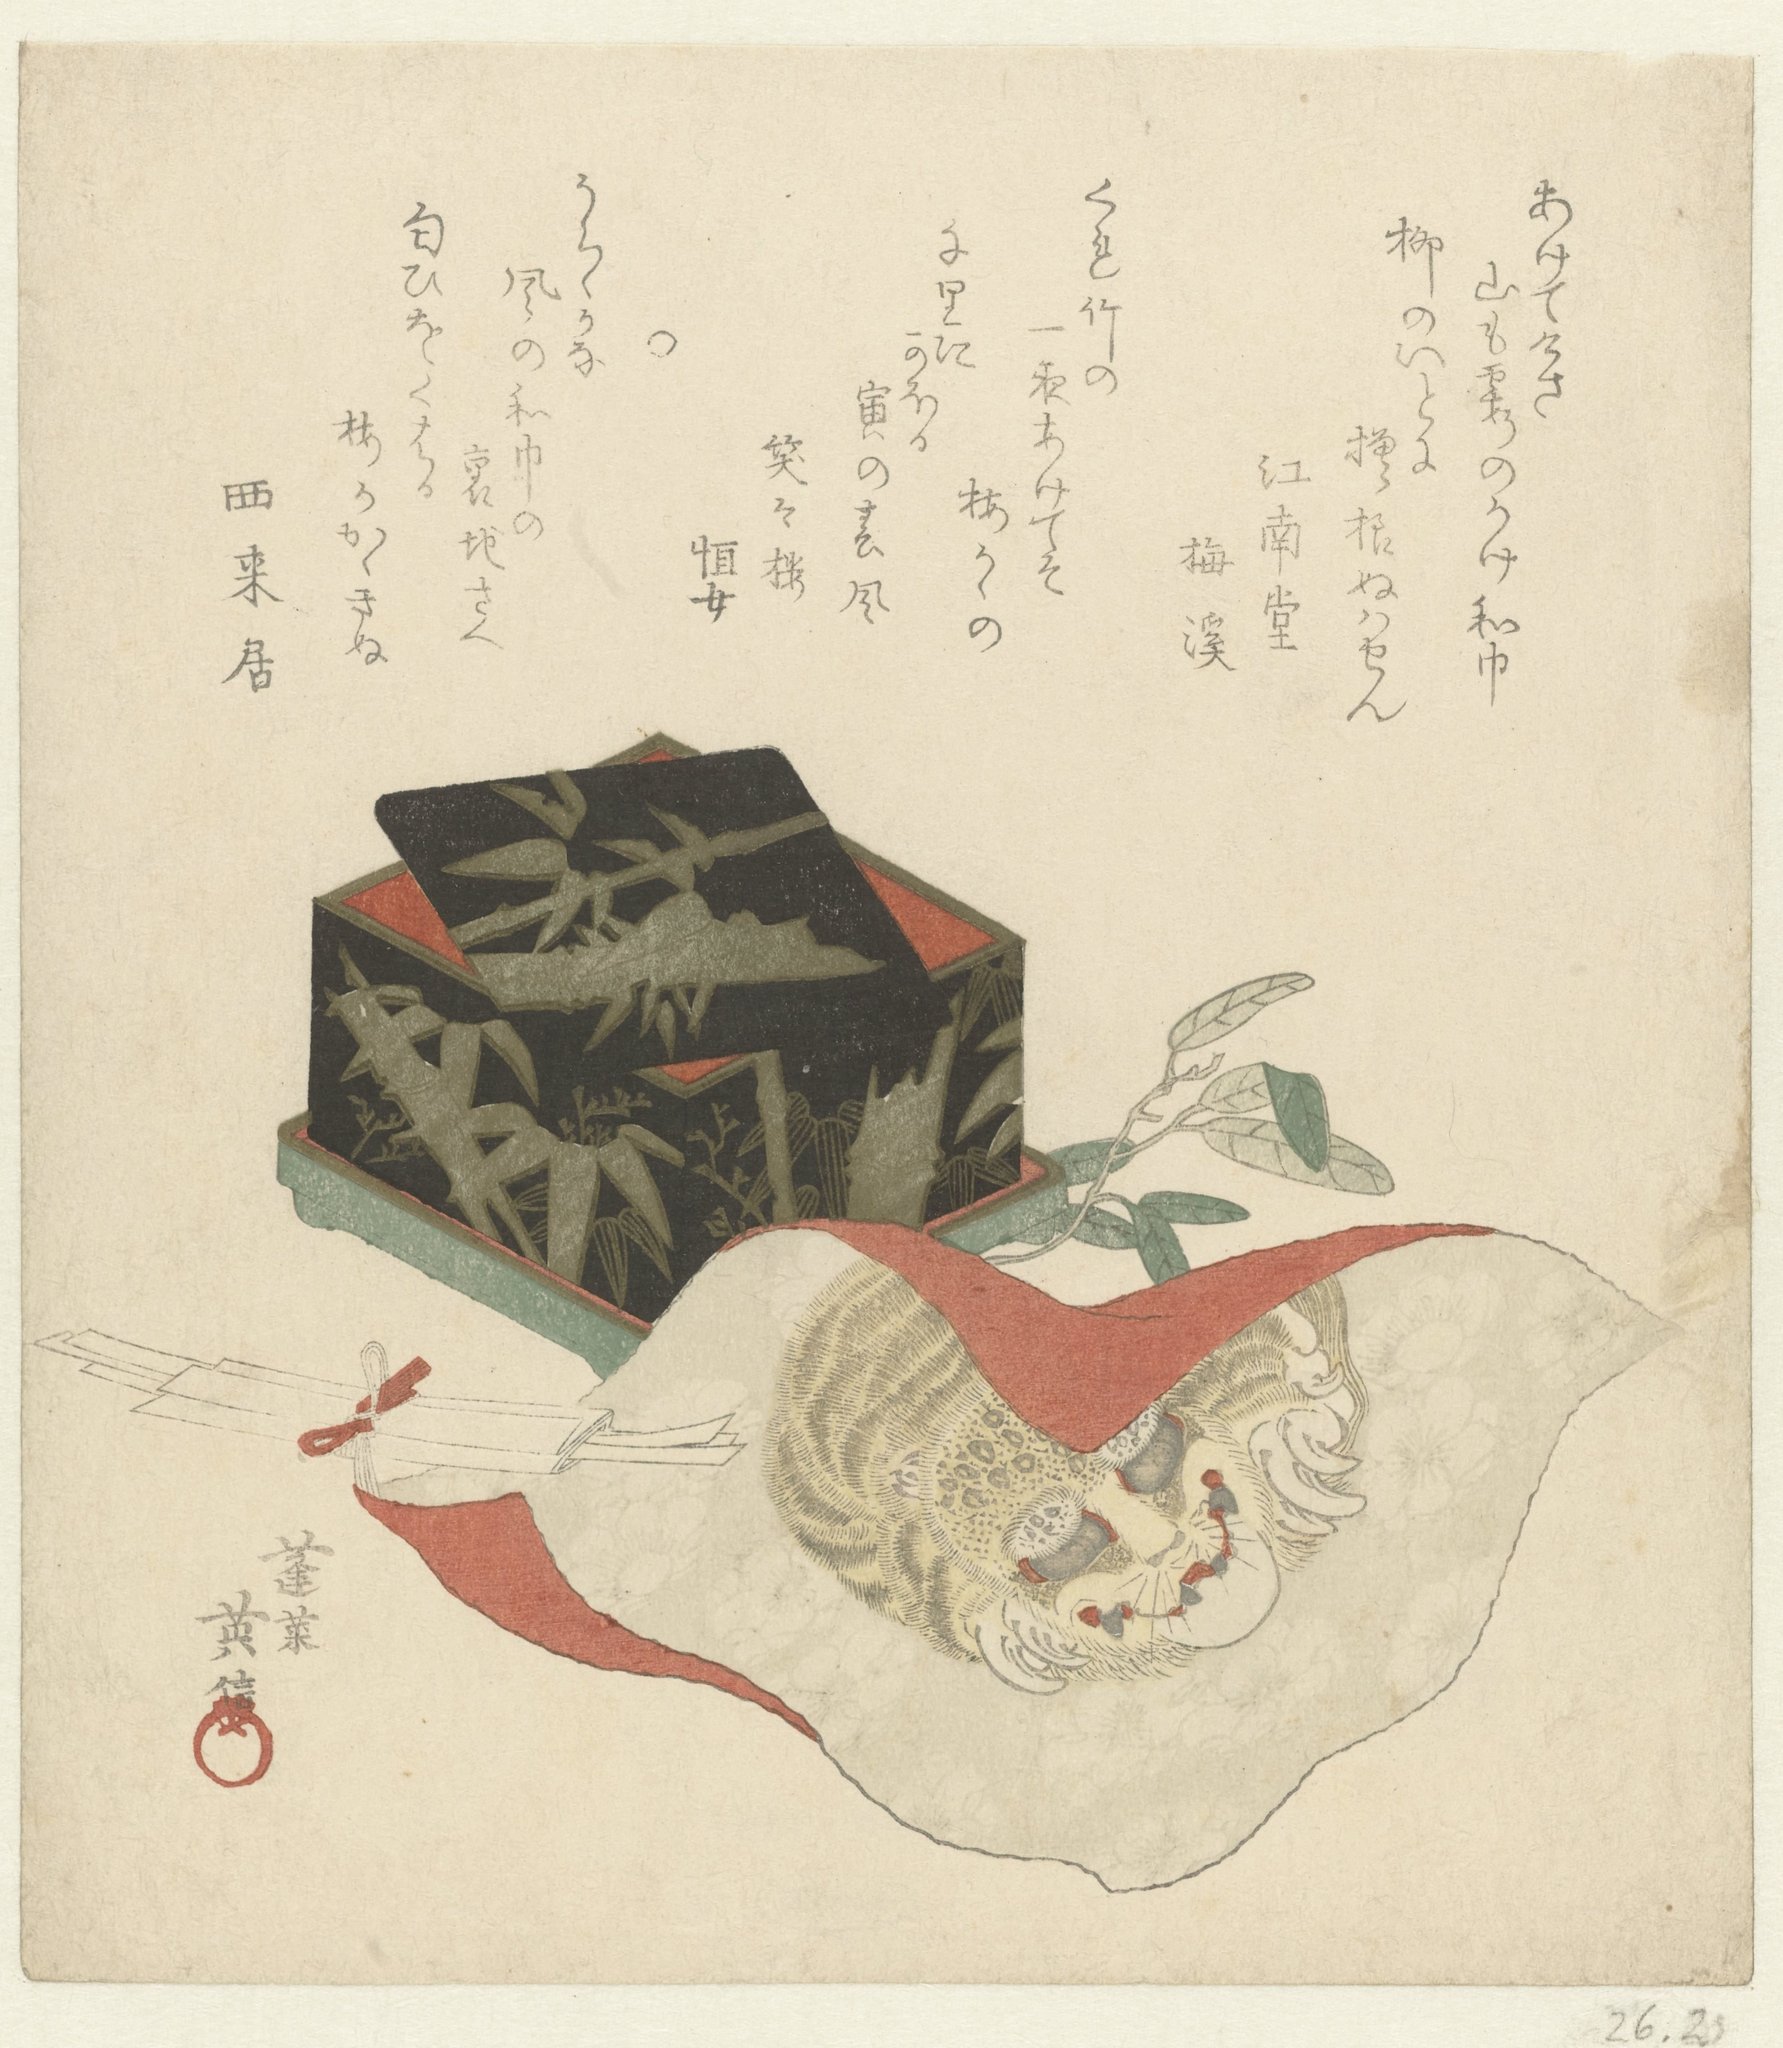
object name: surimono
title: Lakdoos en doek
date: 1818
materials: paper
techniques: blind stamped, woodcut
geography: japan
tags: beasts of prey, predatory animals: tiger, plants; vegetation (+ flowers, blossom, blossoming)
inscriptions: collector's mark, passe-partout, bottom left, printed: JABdH with a rooster., collector's mark, verso, stamped: Lugt 2228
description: Een surimono is een luxe uitgevoerde prent waarop beeld met één of meerdere gedichten gecombineerd is. Bij het drukken van een surimono werd vaak gebruik gemaakt van dikker papier, blinddruk en metaal pigmenten, zoals koper- en zilverpoeder. De prenten werden vaak in opdracht van dichters gemaakt en als exclusief geschenk aan vrienden en relaties gegeven.